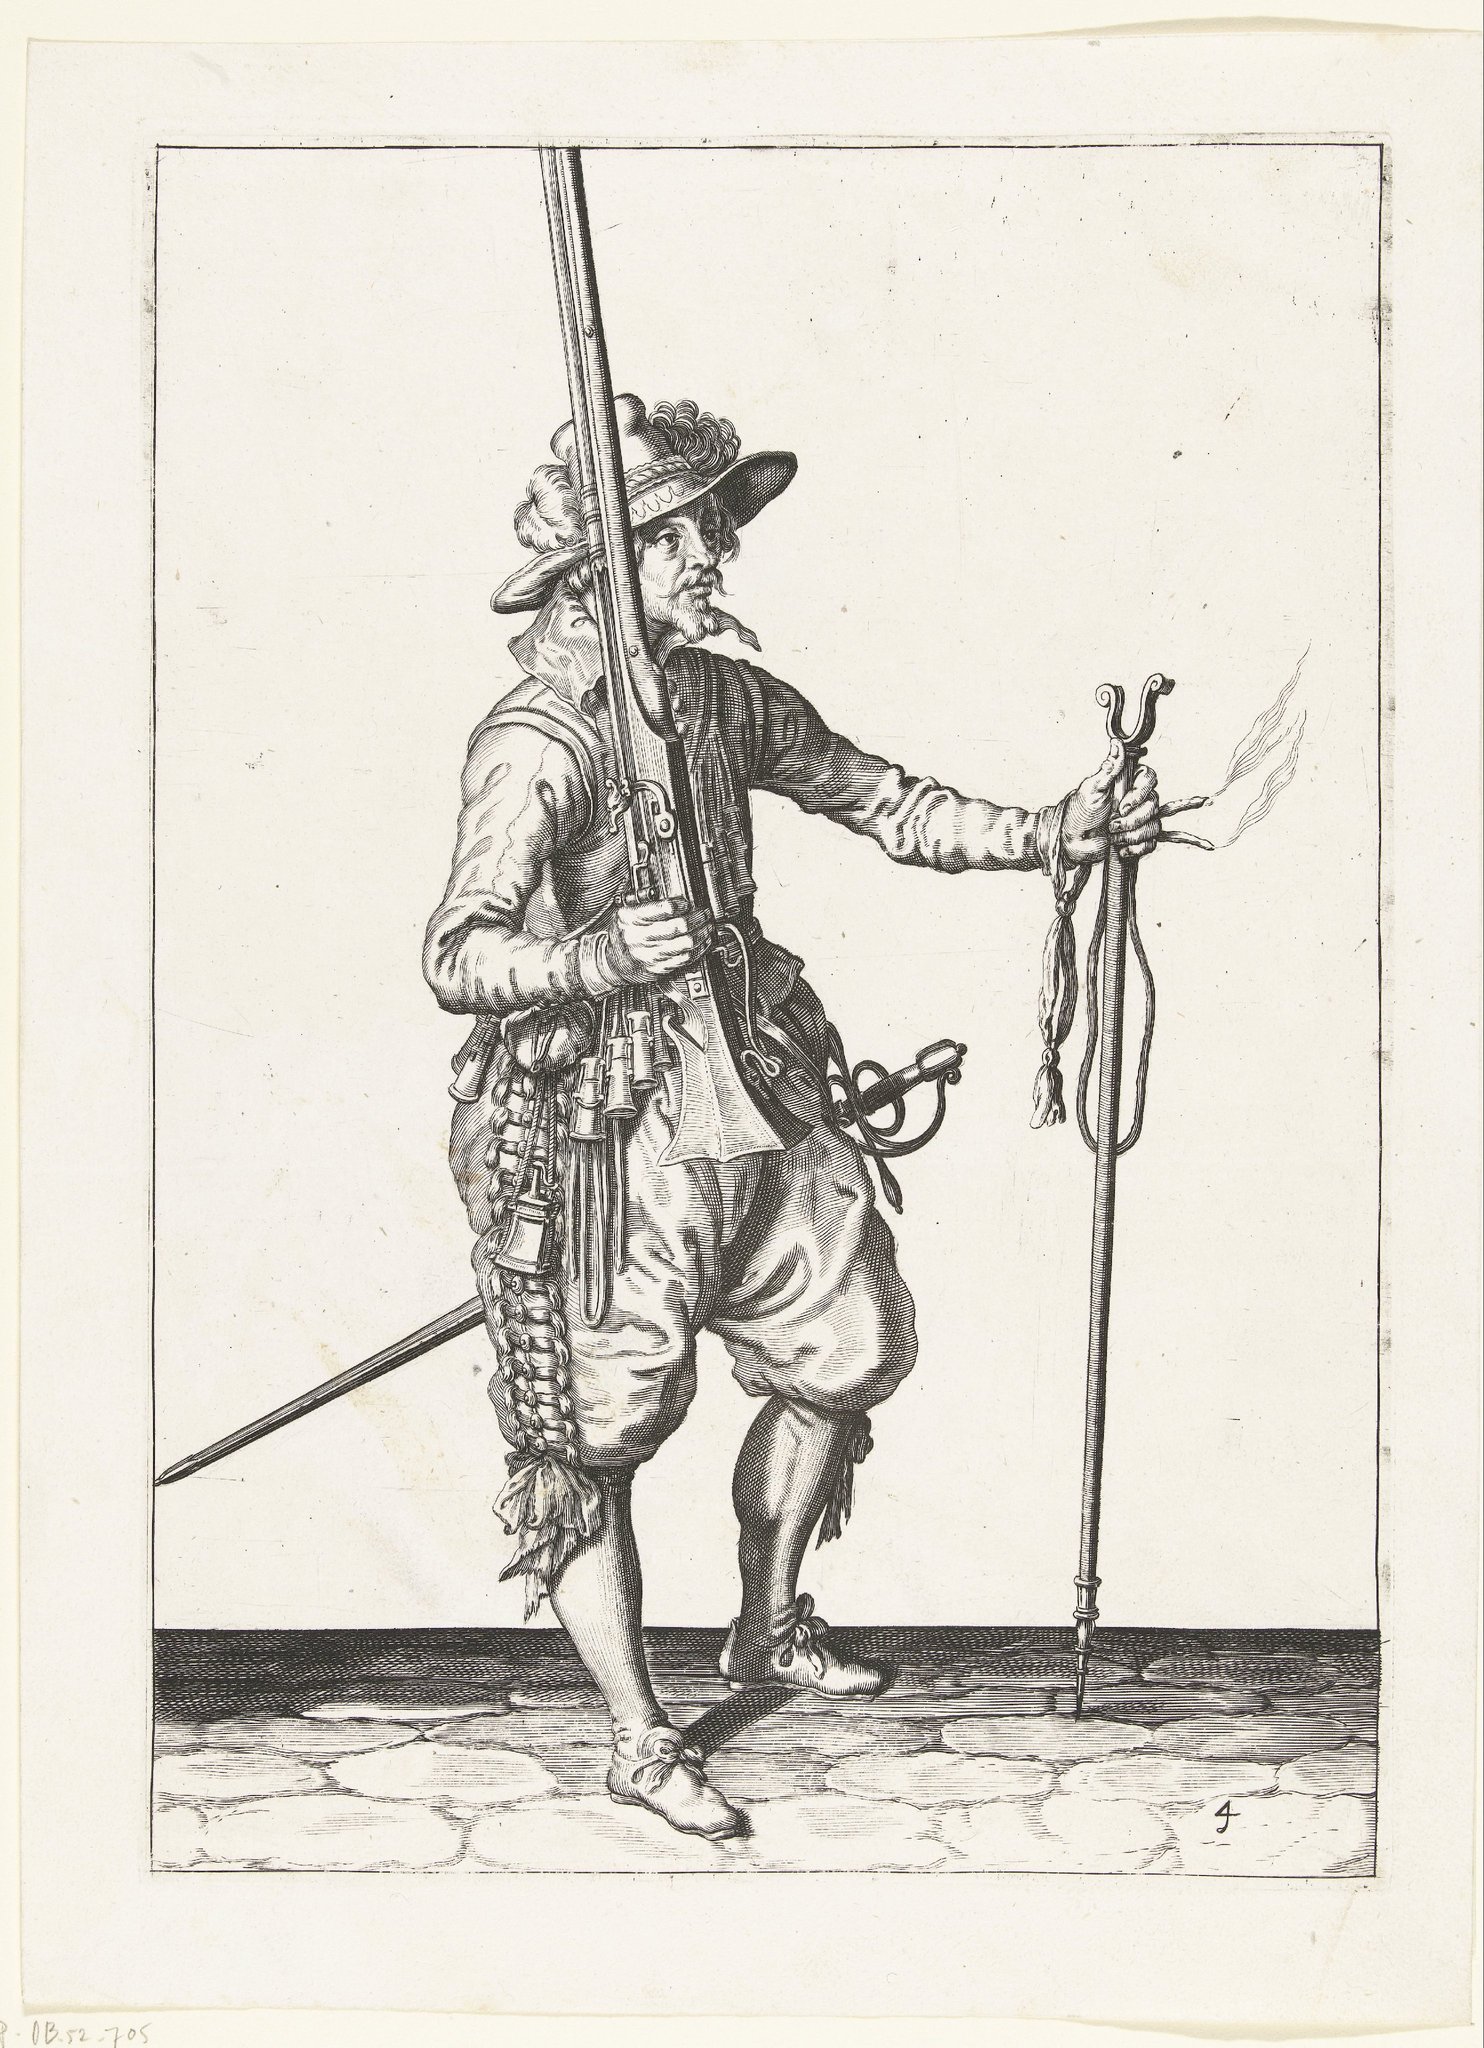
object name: print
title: Wapenhandelinghe van Roers Musquetten ende Spiessen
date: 1597-1607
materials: paper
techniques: engraving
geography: netherlands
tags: manoeuvre ~ military training, firearms: rifle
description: Een soldaat, ten voeten uit, naar rechts, die een musket (een bepaald type vuurwapen) met zijn rechterhand vasthoudt, de loop omhoog wijzend. In zijn uitgestoken linkerhand een brandende lont en een furket (musketvork), waarop hij zijn wapen kan plaatsen. Deze prent is onderdeel van de reeks van 43 genummerde prenten van musketiers uit de Wapenhandelinghe.